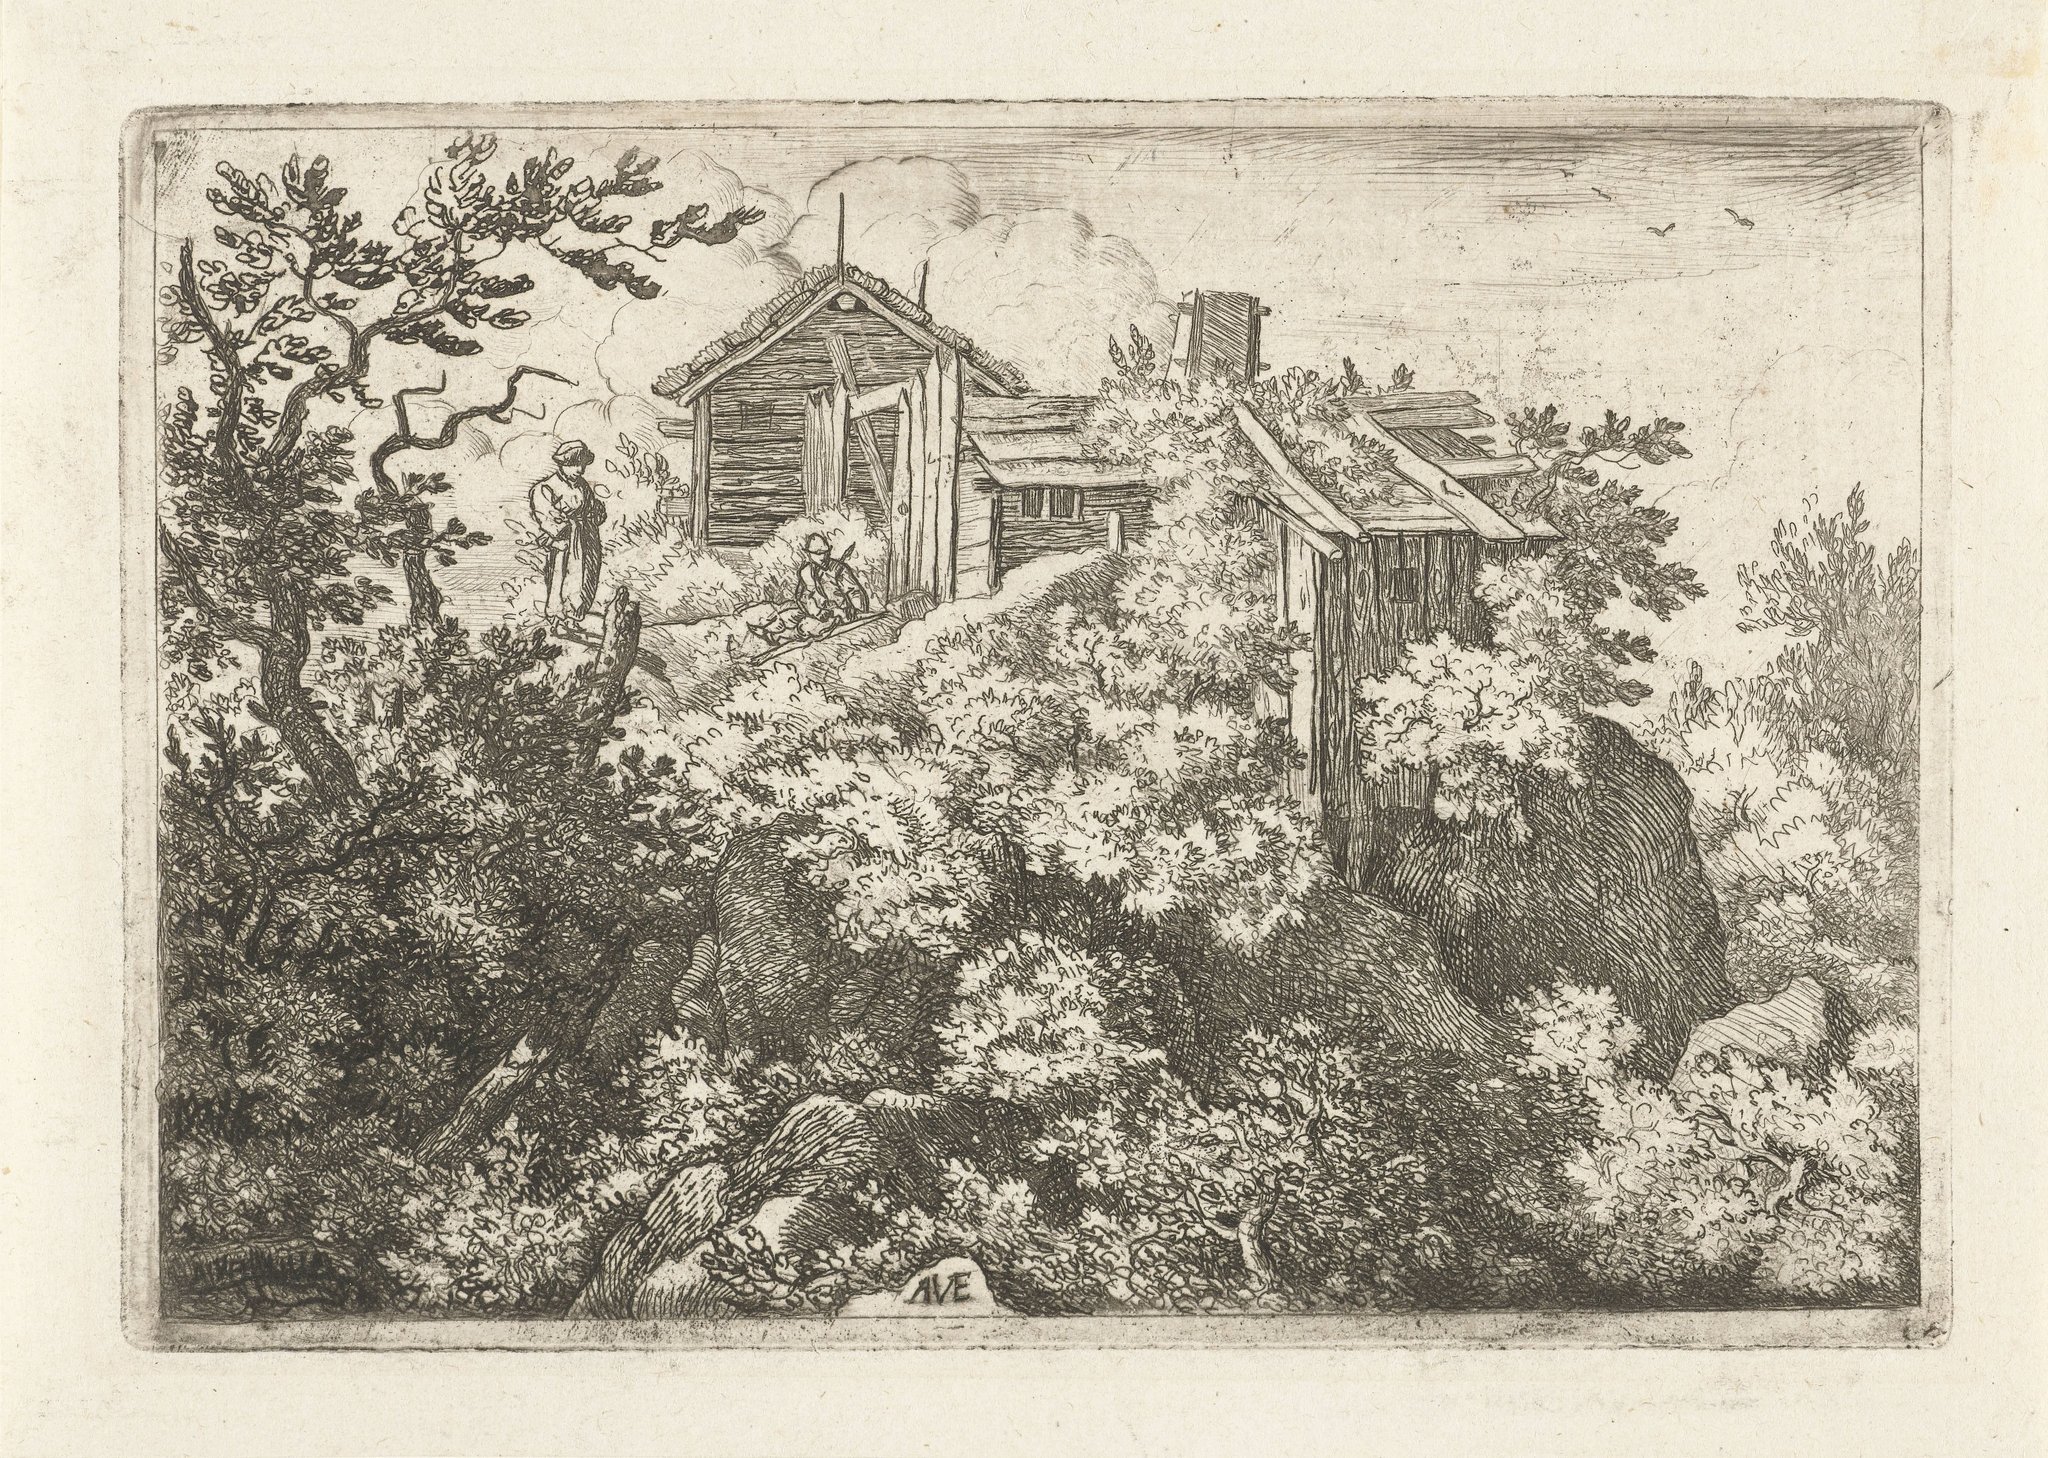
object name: print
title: Drie huisjes op een rots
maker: allaert van everdingen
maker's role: draughtsman, painter, print maker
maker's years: 1621-1675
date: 1631-1675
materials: paper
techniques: etching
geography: netherlands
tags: farm or solitary house in landscape (+ city(-scape) with figures, staffage)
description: Gezicht op houten huisjes op een rots begroeid met bomen en struikgewas. Op een open plek een staand en zittend persoon.